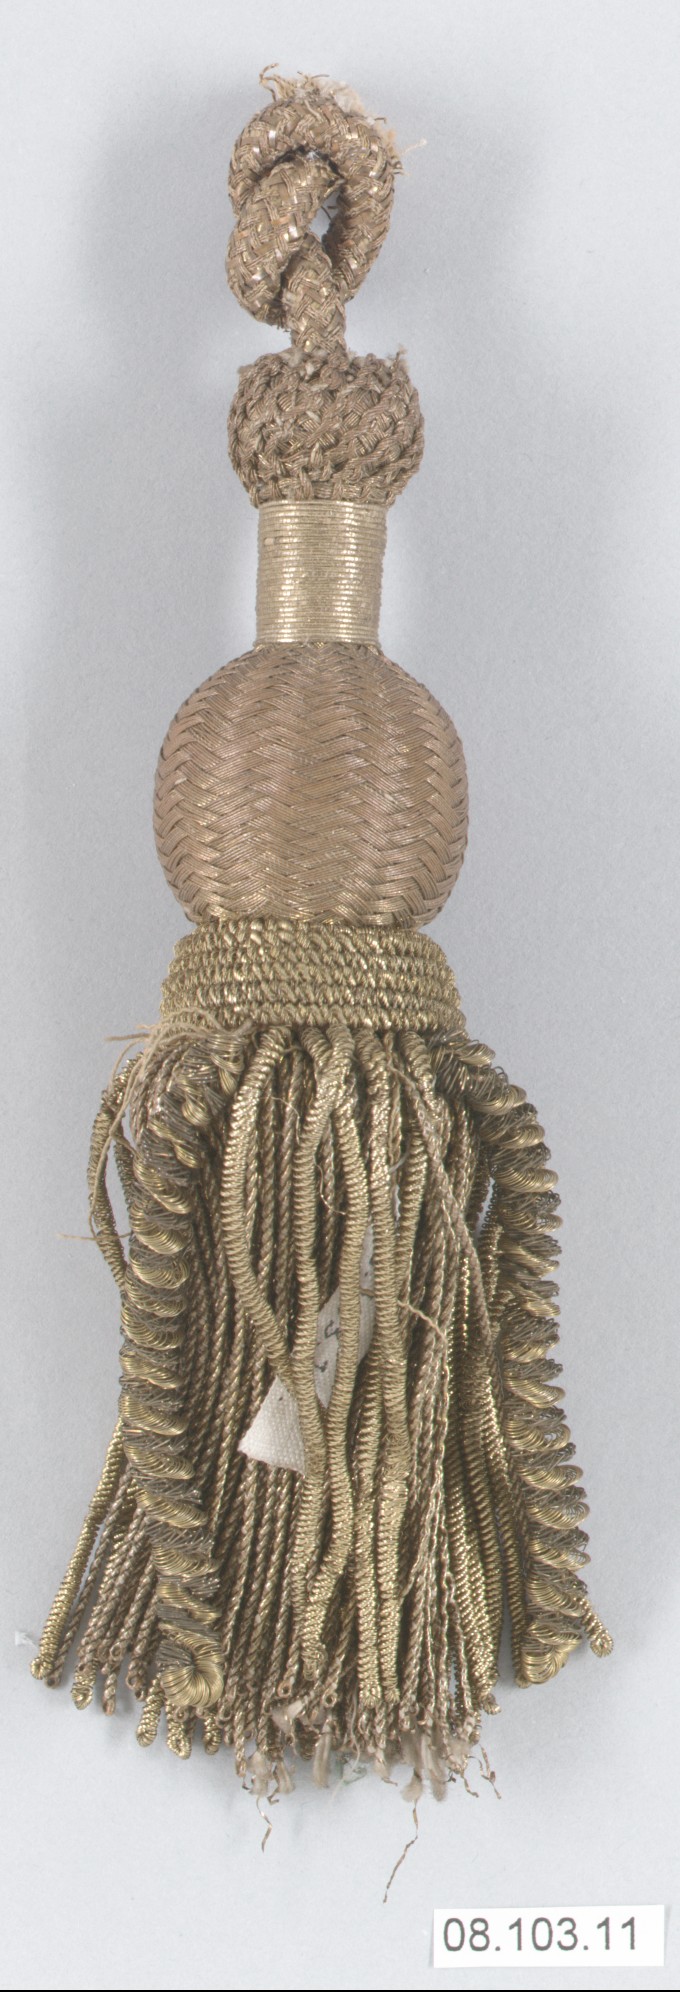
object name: tassel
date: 1701-1900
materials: metal thread